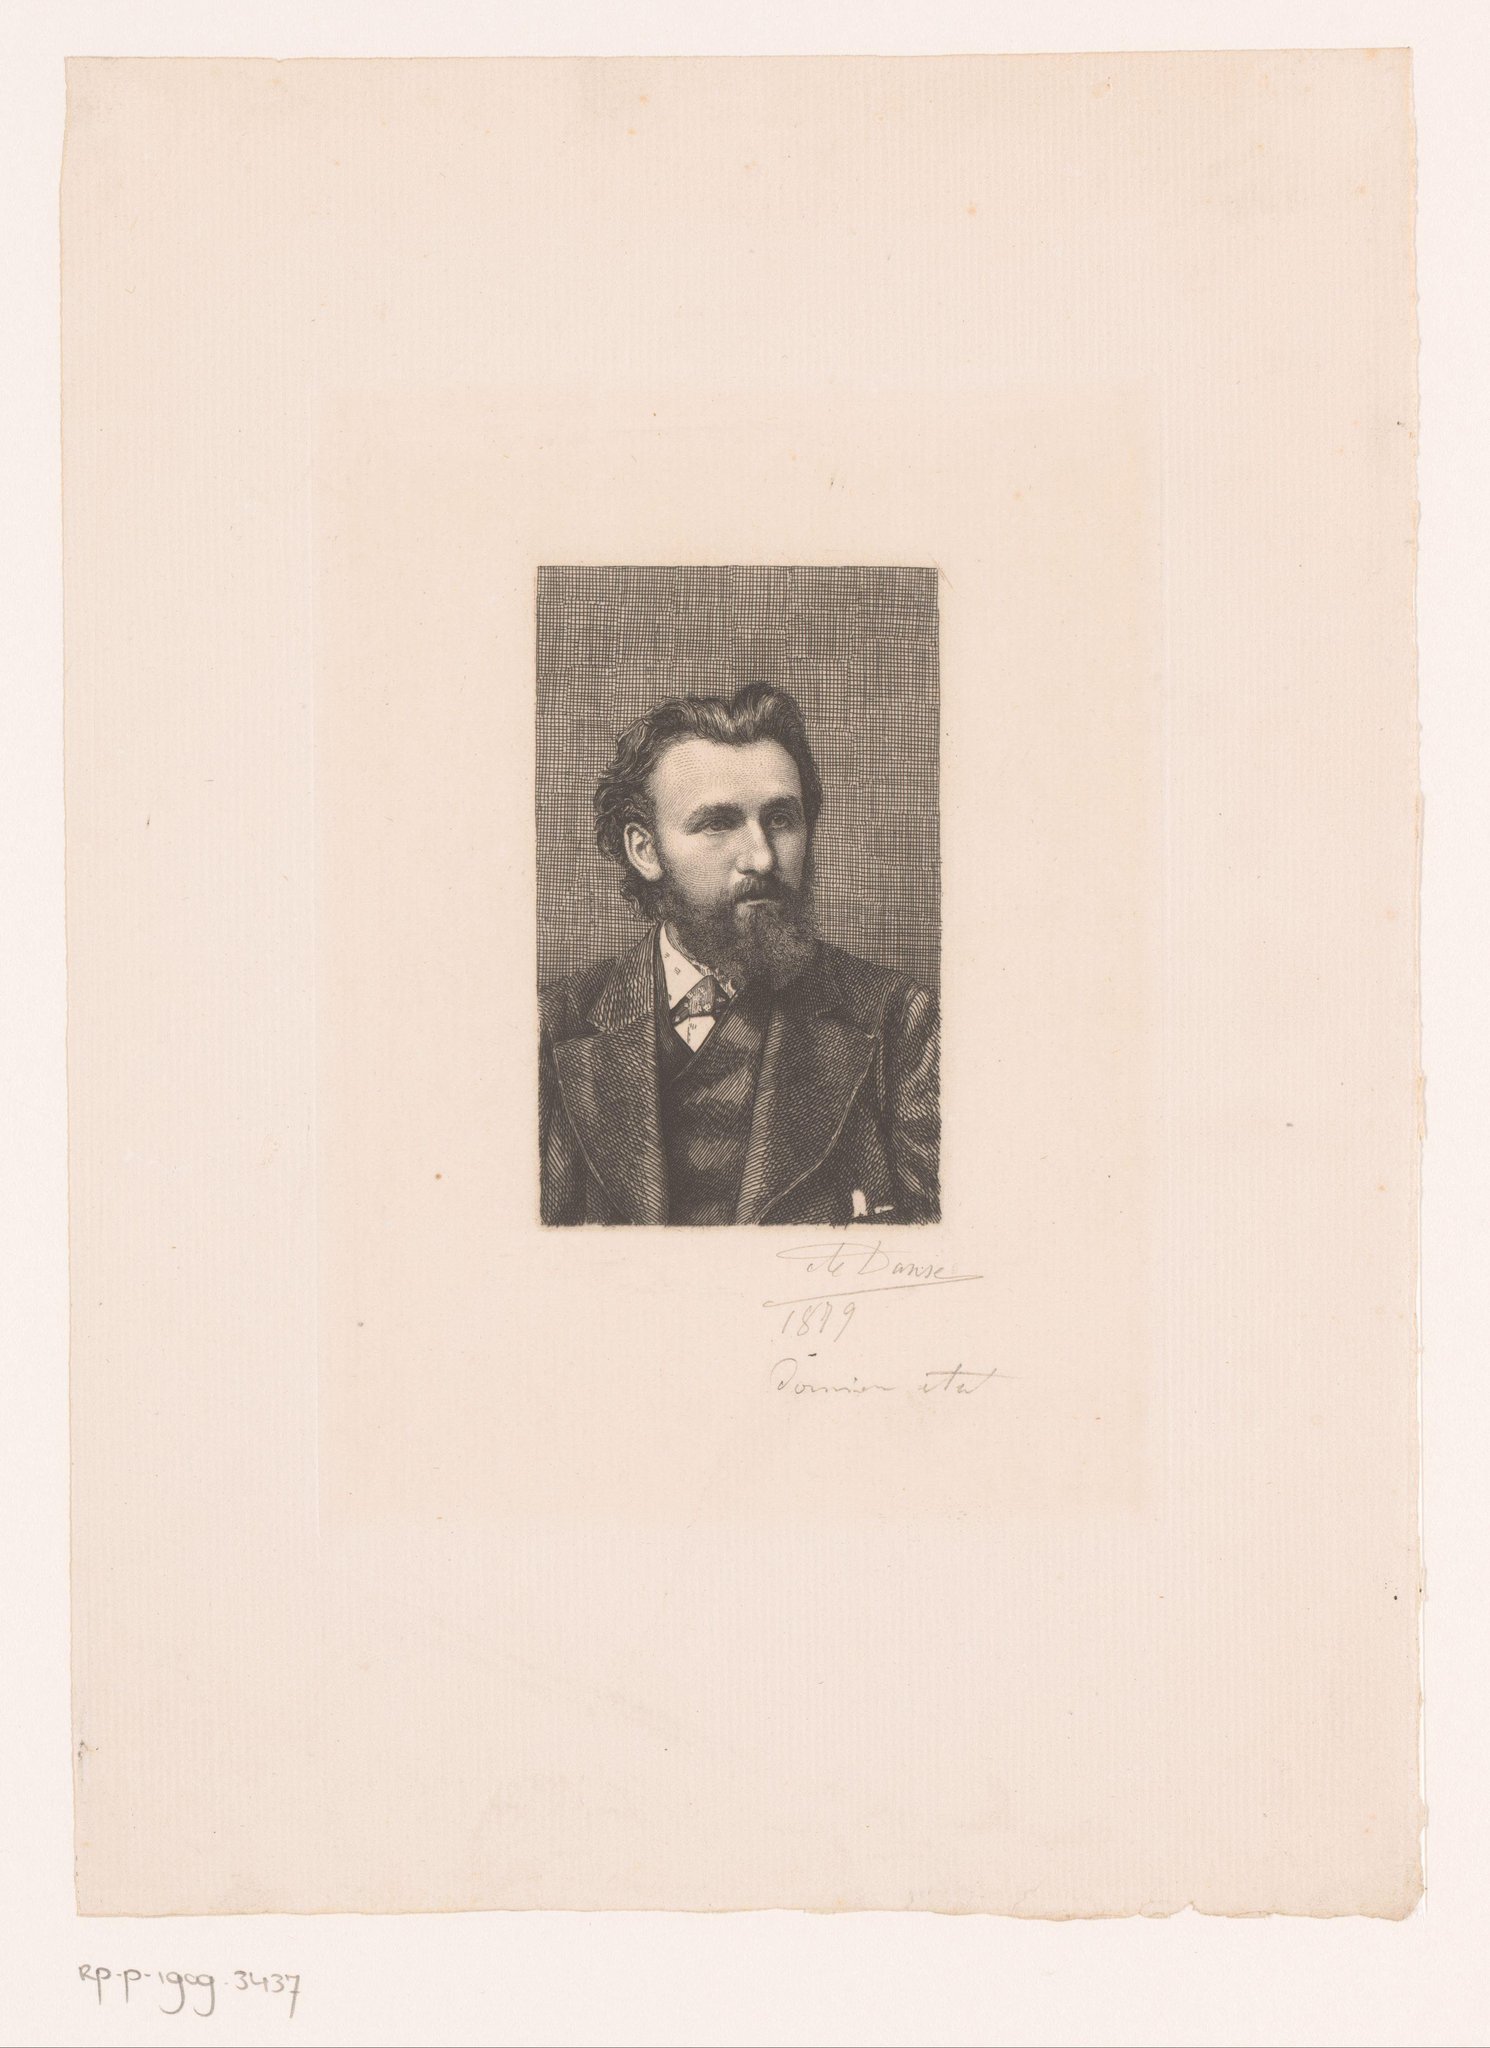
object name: print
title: Portret van Alexandre Batta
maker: auguste danse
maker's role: print maker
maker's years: 1829-1929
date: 1879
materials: paper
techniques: etching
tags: maastricht, musician, historical person (...) - historical person (...) portrayed alone, portrait of a musician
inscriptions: collector's mark: Lugt 2228, annotation: ‘dernier etat’